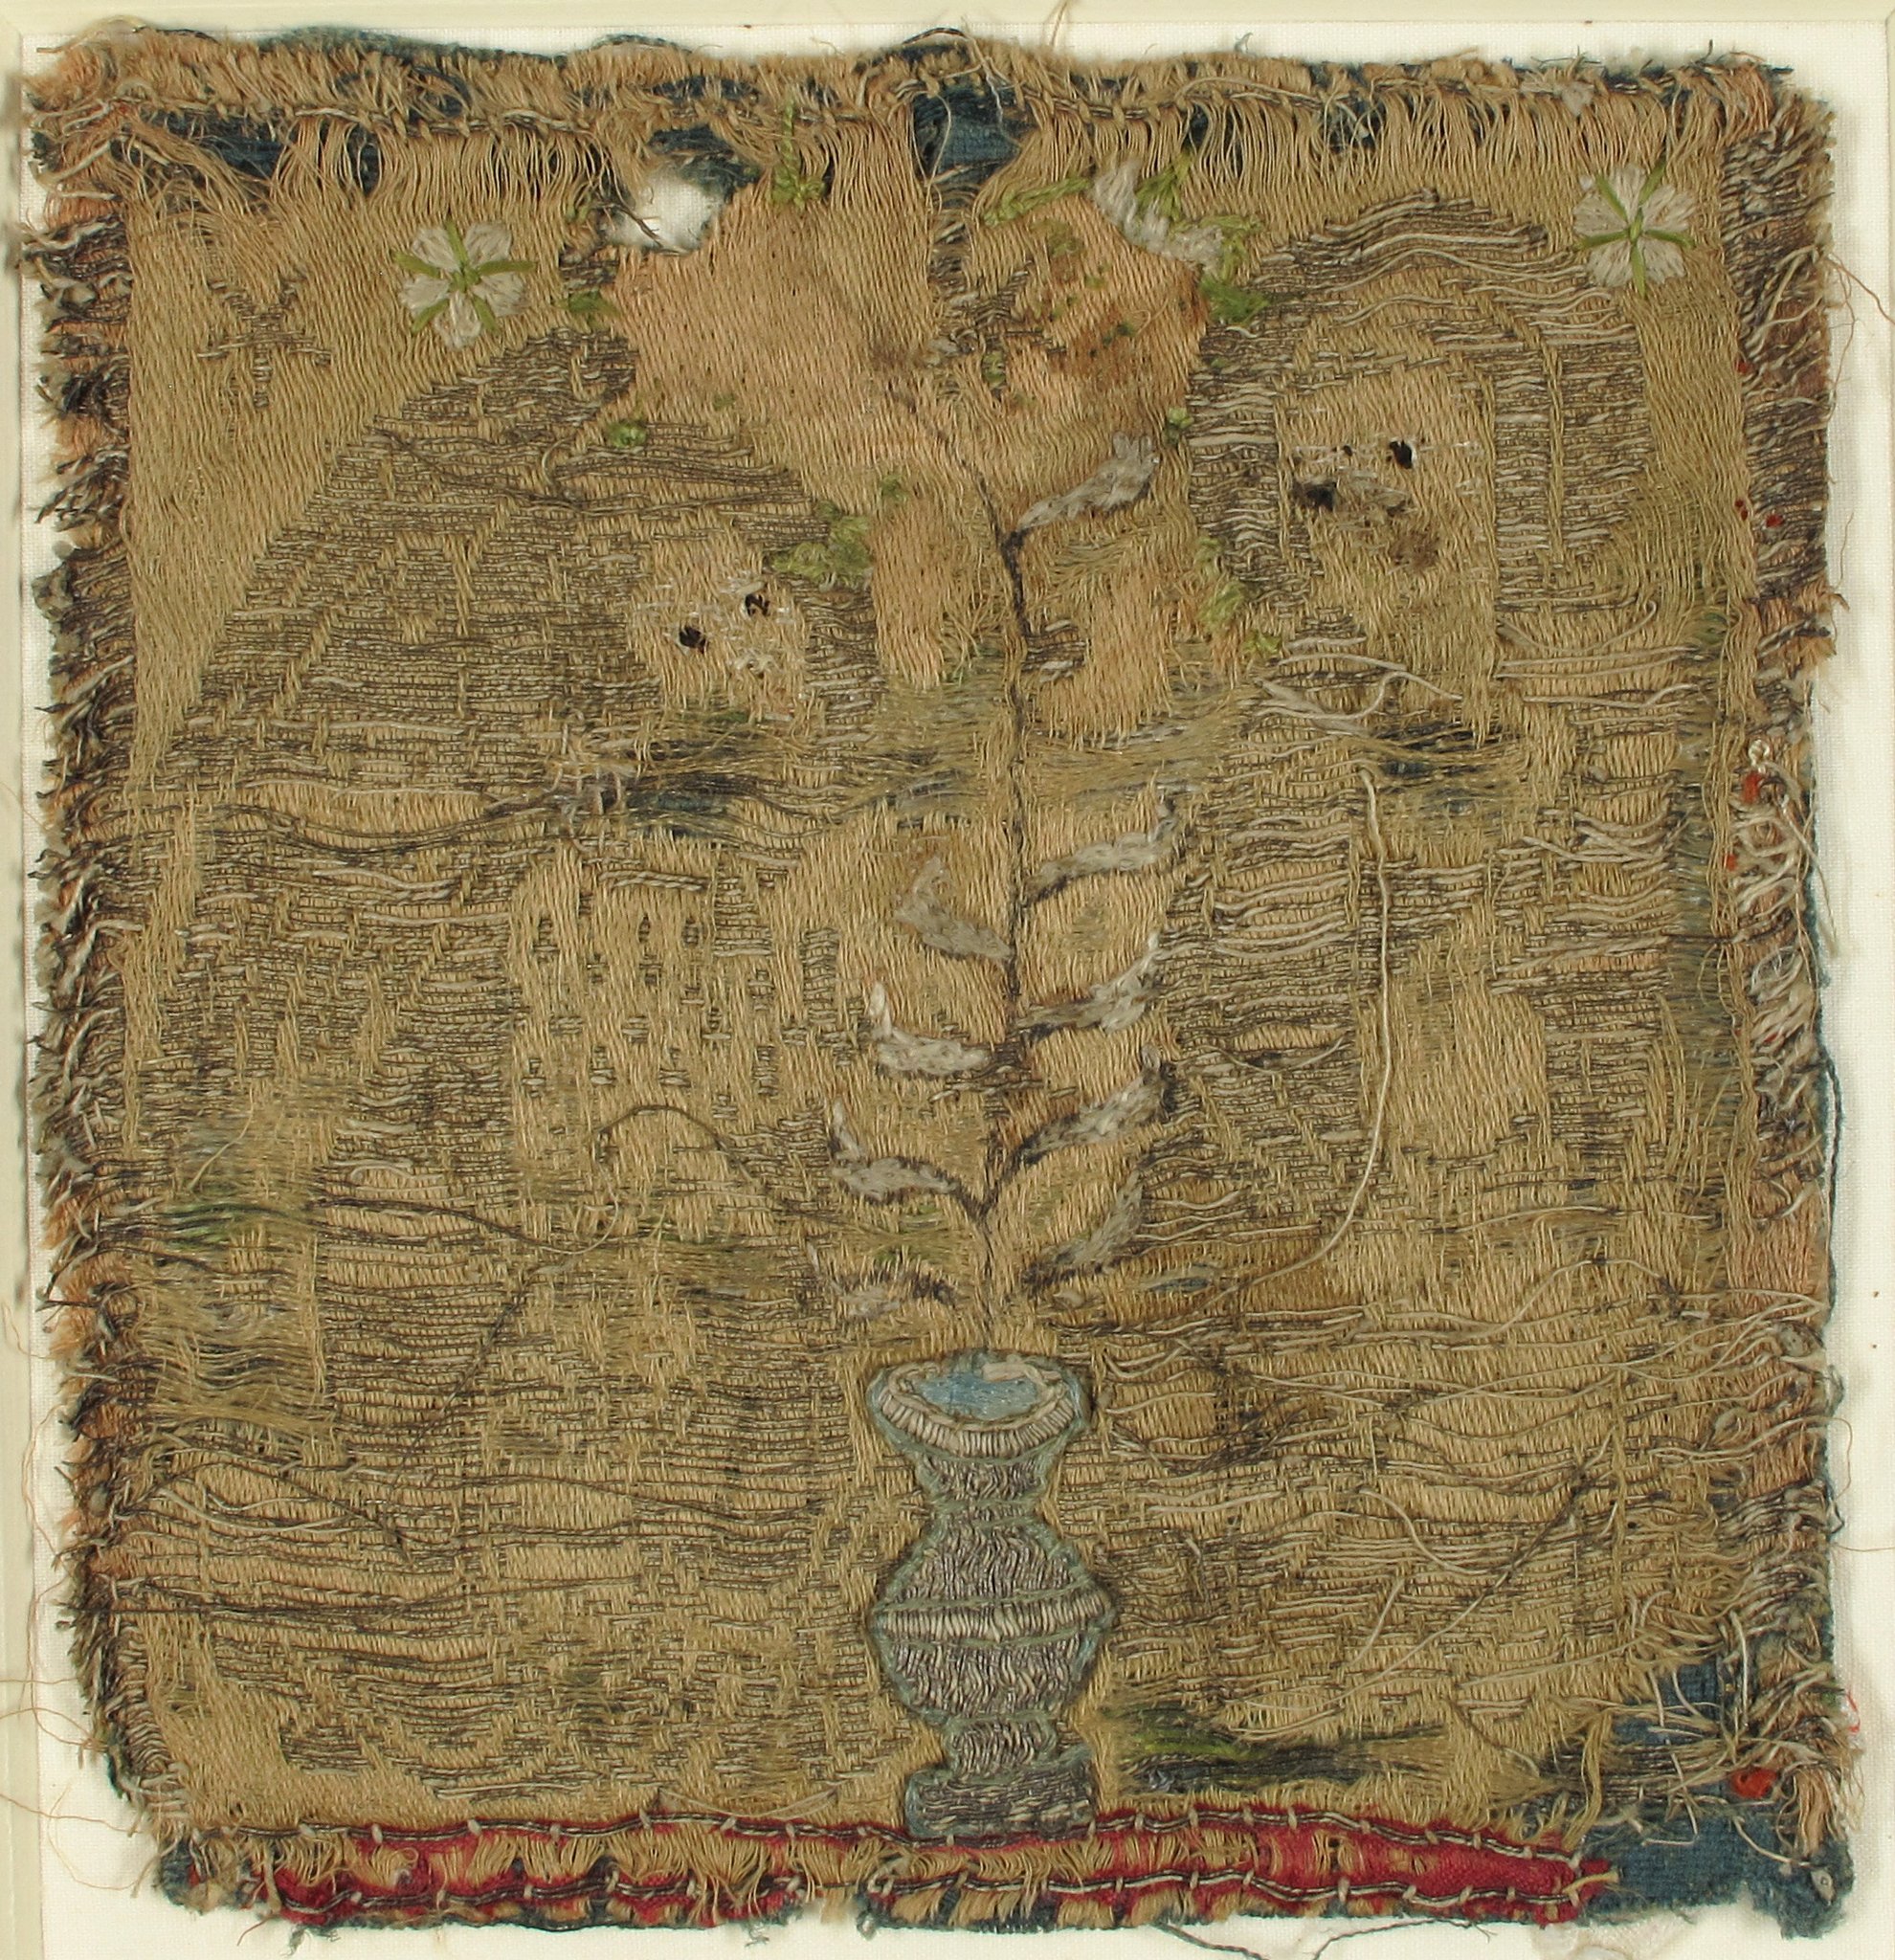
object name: textile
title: Textile with Brocade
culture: italian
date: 1401-1500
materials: gold thread, linen, silk